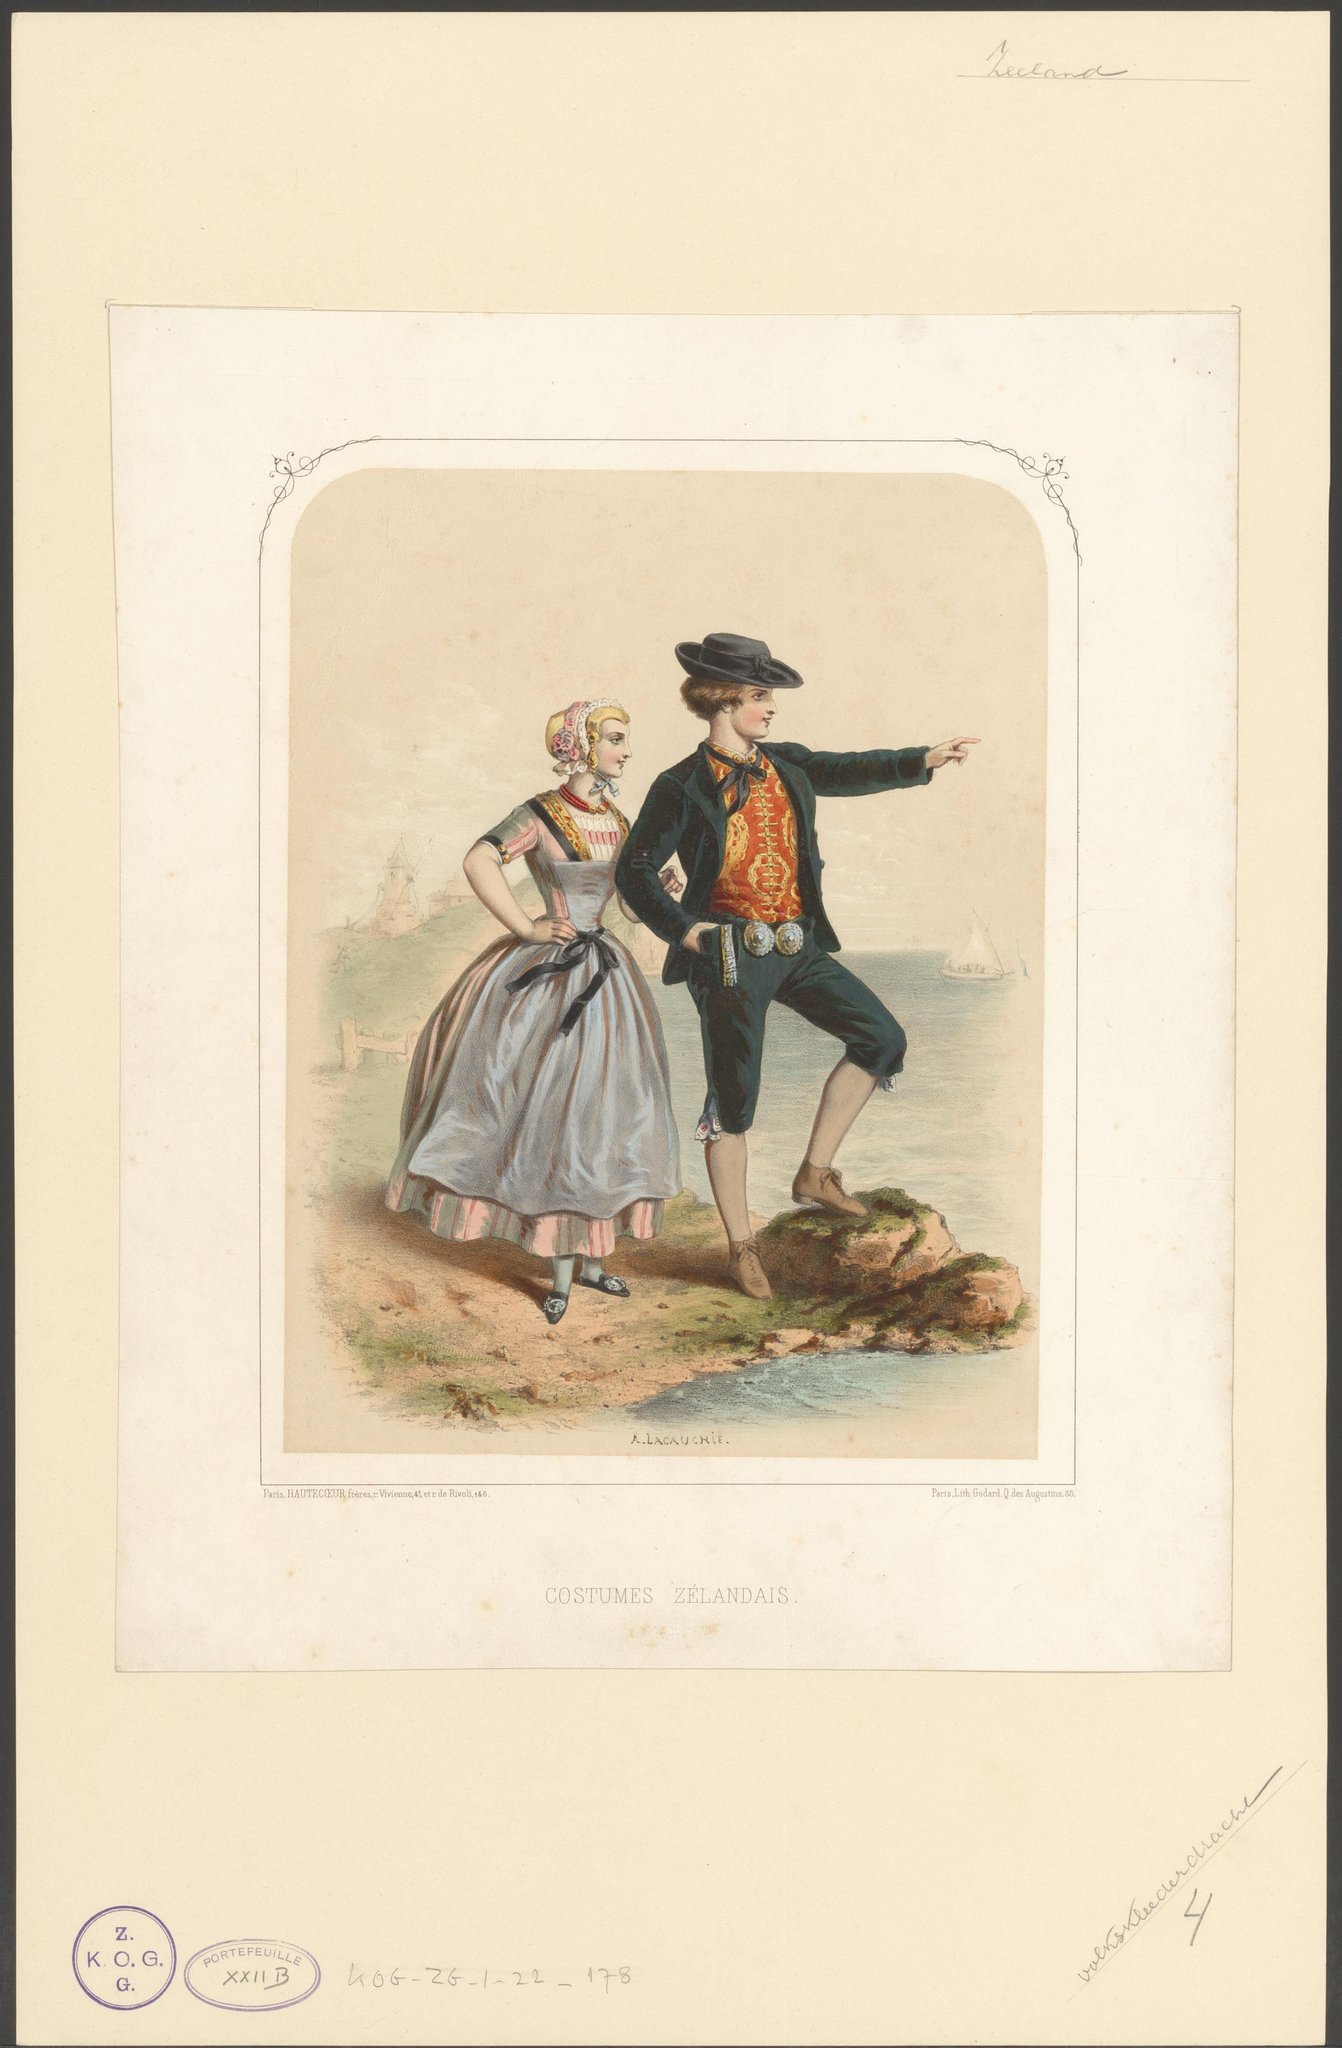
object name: print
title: Costumes Zélandais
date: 1830-1860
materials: paper, watercolor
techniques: hand coloring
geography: paris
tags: clothes, costume (+ women's clothes), clothes, costume (+ men's clothes), folk costume, regional costume, zeeland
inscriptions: collector's mark, collector's mark: Lugt 1641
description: Jonge man en jonge vrouw staande aan de kust, gekleed in Zeeuwse klederdracht. Onderwerpsrubrieken binnen de Atlas Zeden en Gewoonten: De Kleeding, Volkskleederdracht, Zeeland.